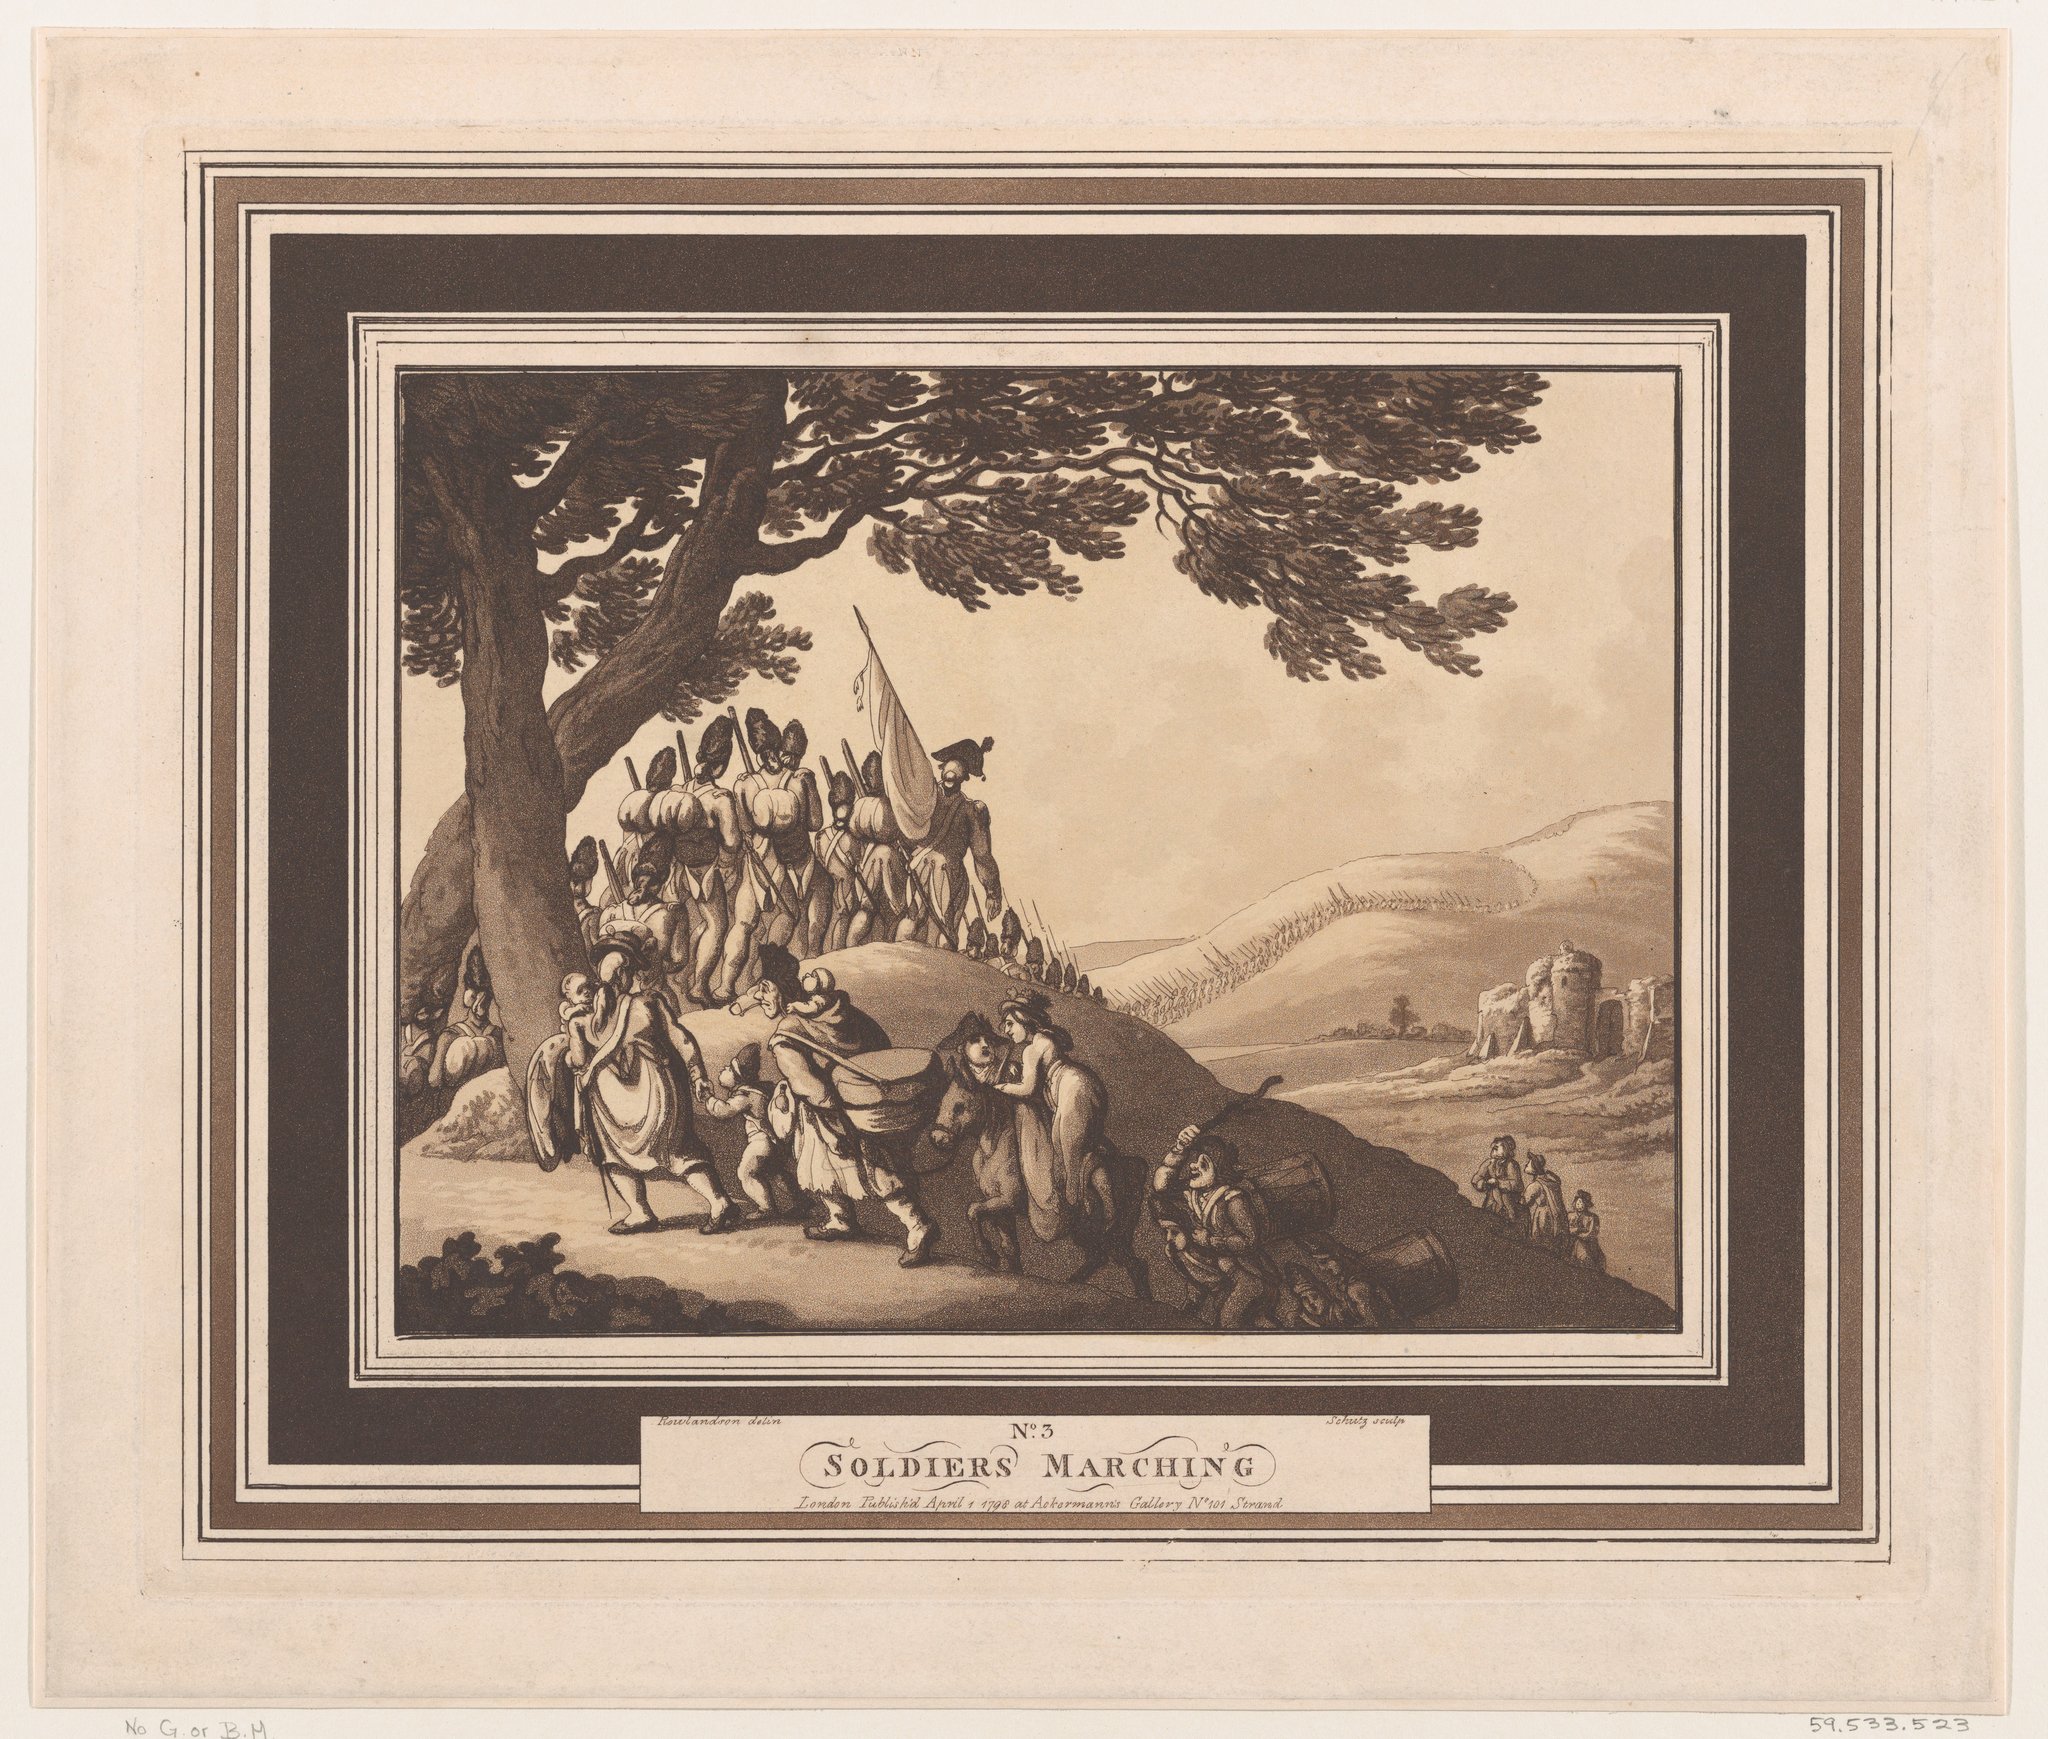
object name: print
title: Soldiers Marching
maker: heinrich joseph schütz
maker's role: artist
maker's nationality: german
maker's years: 1800-1825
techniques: aquatint, etching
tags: soldiers,men,women